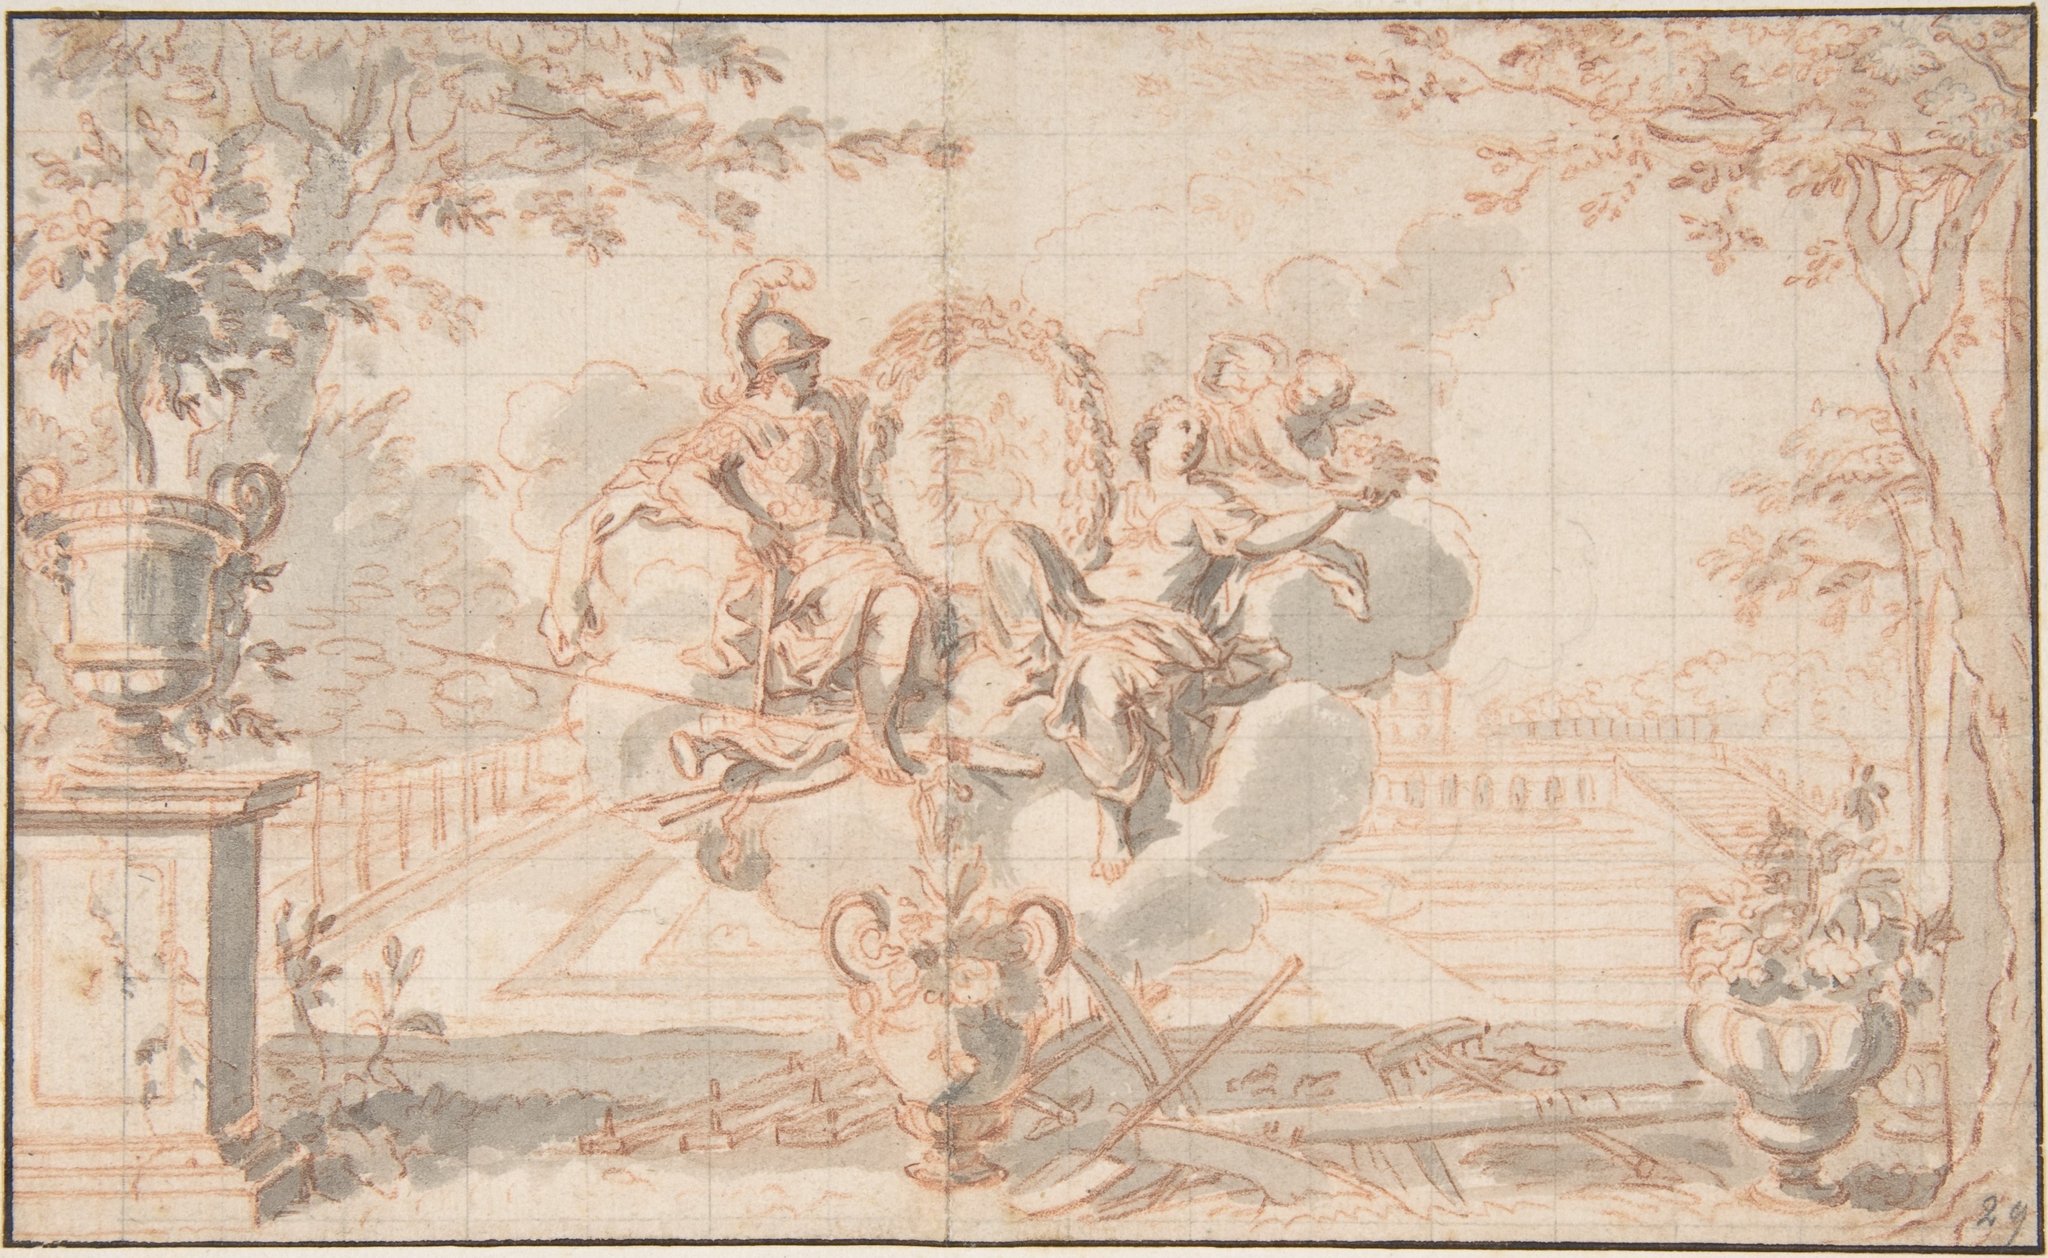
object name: drawing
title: Allegory of Spring, after Sébastien Leclerc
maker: anonymous, french, 18th century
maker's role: artist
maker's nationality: french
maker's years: 1700-1800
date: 1701-1800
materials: chalk, graphite, ink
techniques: brush, pen, drawing, wash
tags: soldiers,trees,spring